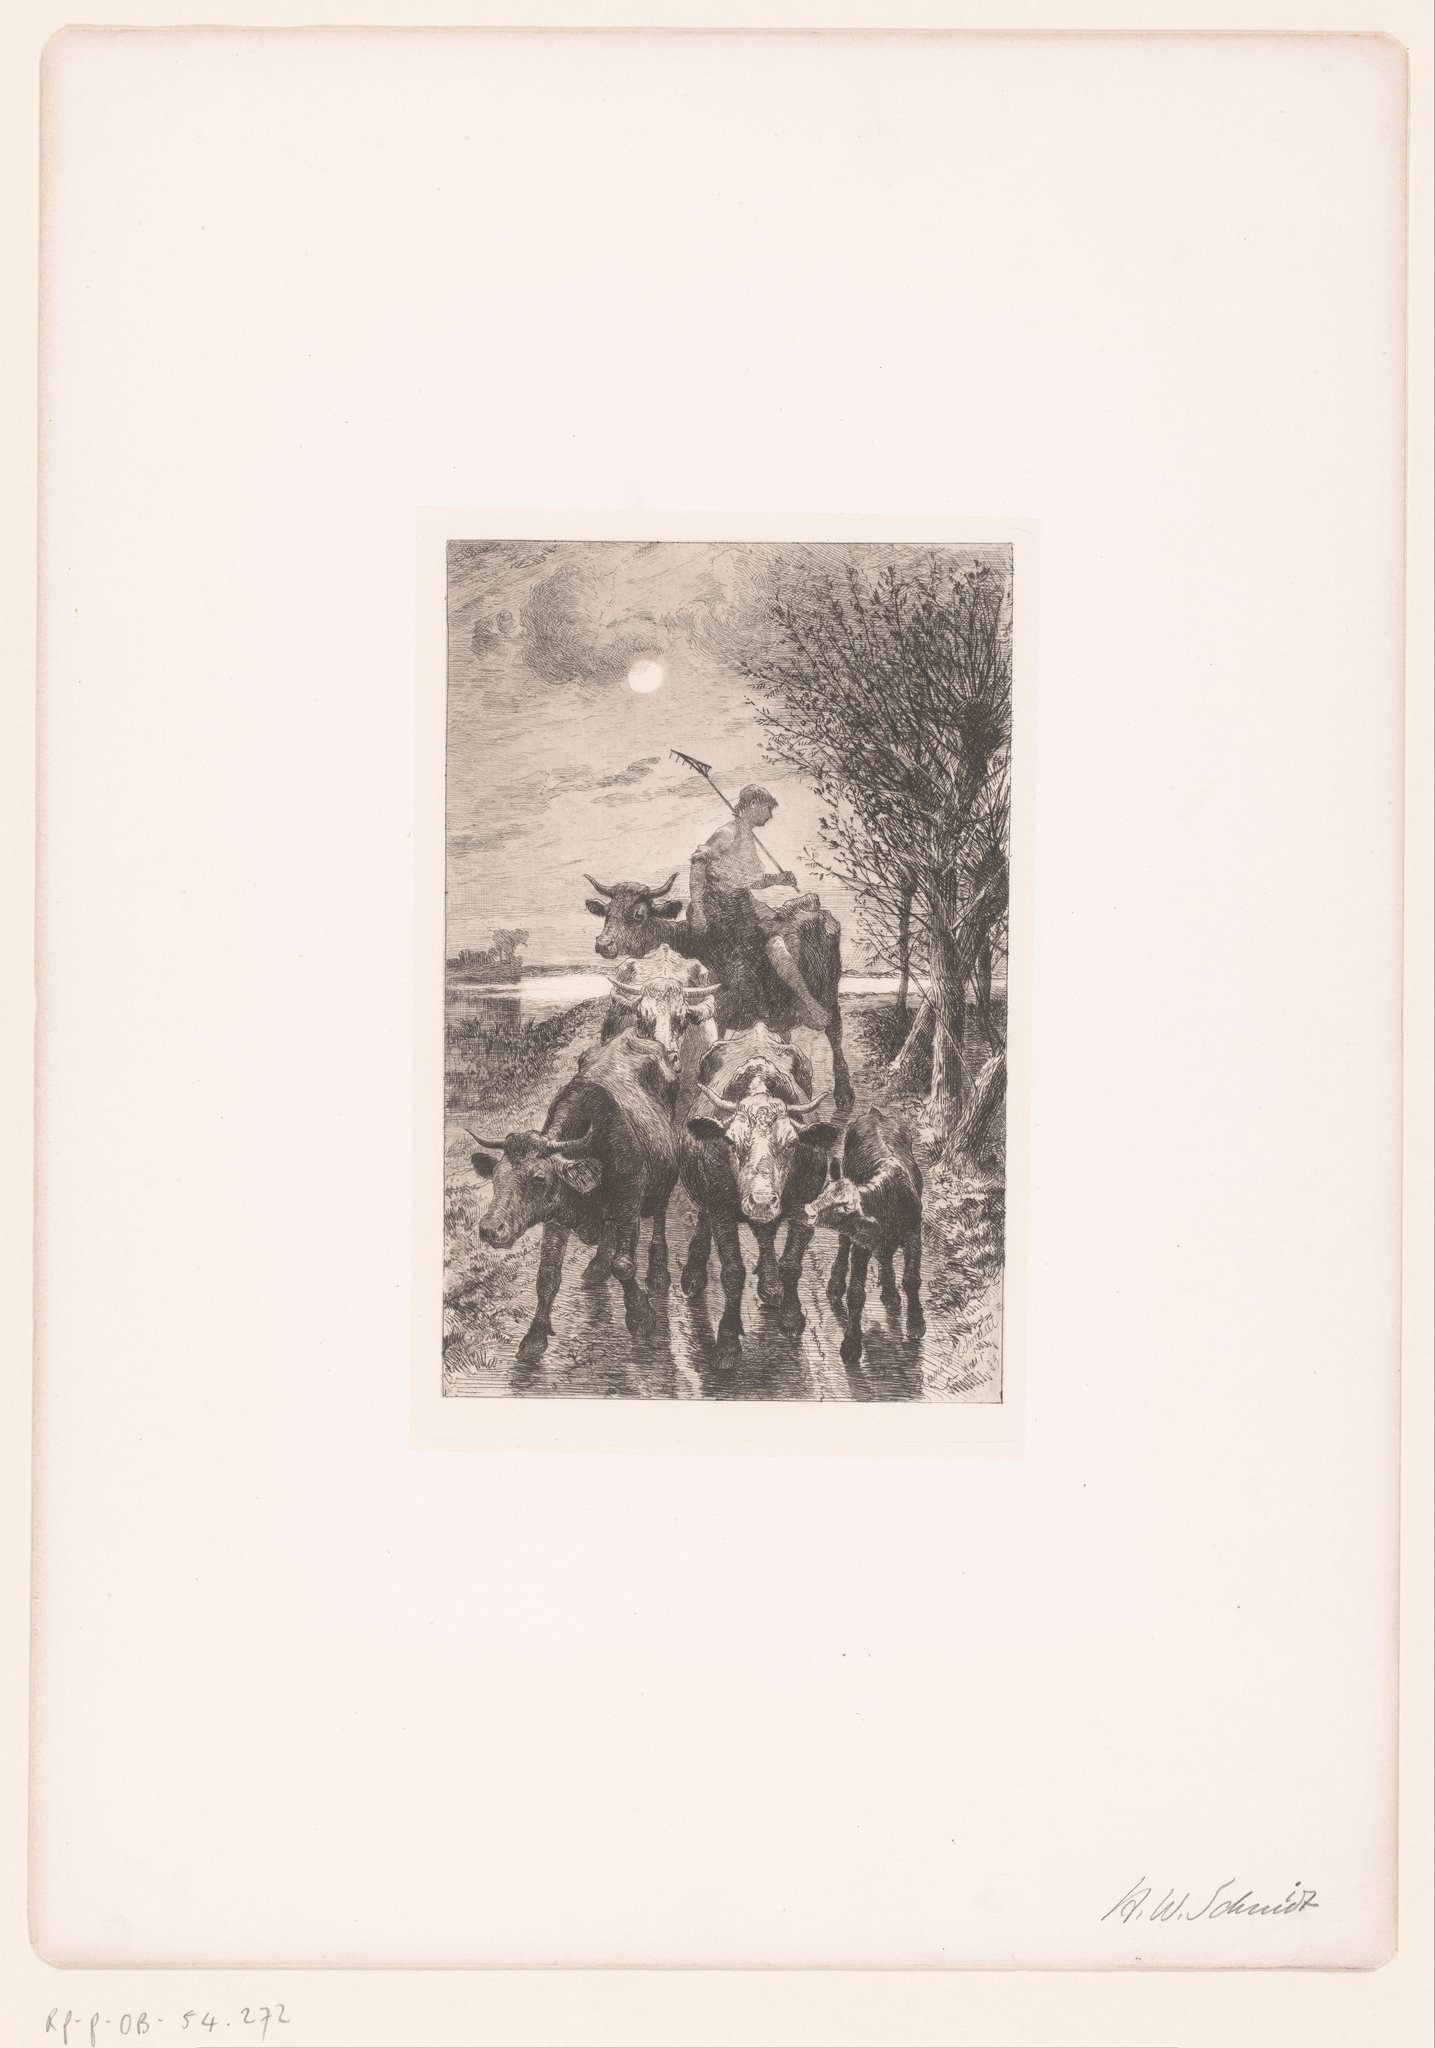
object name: print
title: Kudde koeien met herderin met hark op de achterste koe gezeten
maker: hans w. schmidt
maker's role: print maker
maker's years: 1859-1950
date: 1883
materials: paper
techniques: etching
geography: weimar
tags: cow, herding, herdsman, herdswoman, shepherd, shepherdess, cowherd, etc.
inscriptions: collector's mark: Lugt 2228, : ‘H.W. Schmidt’